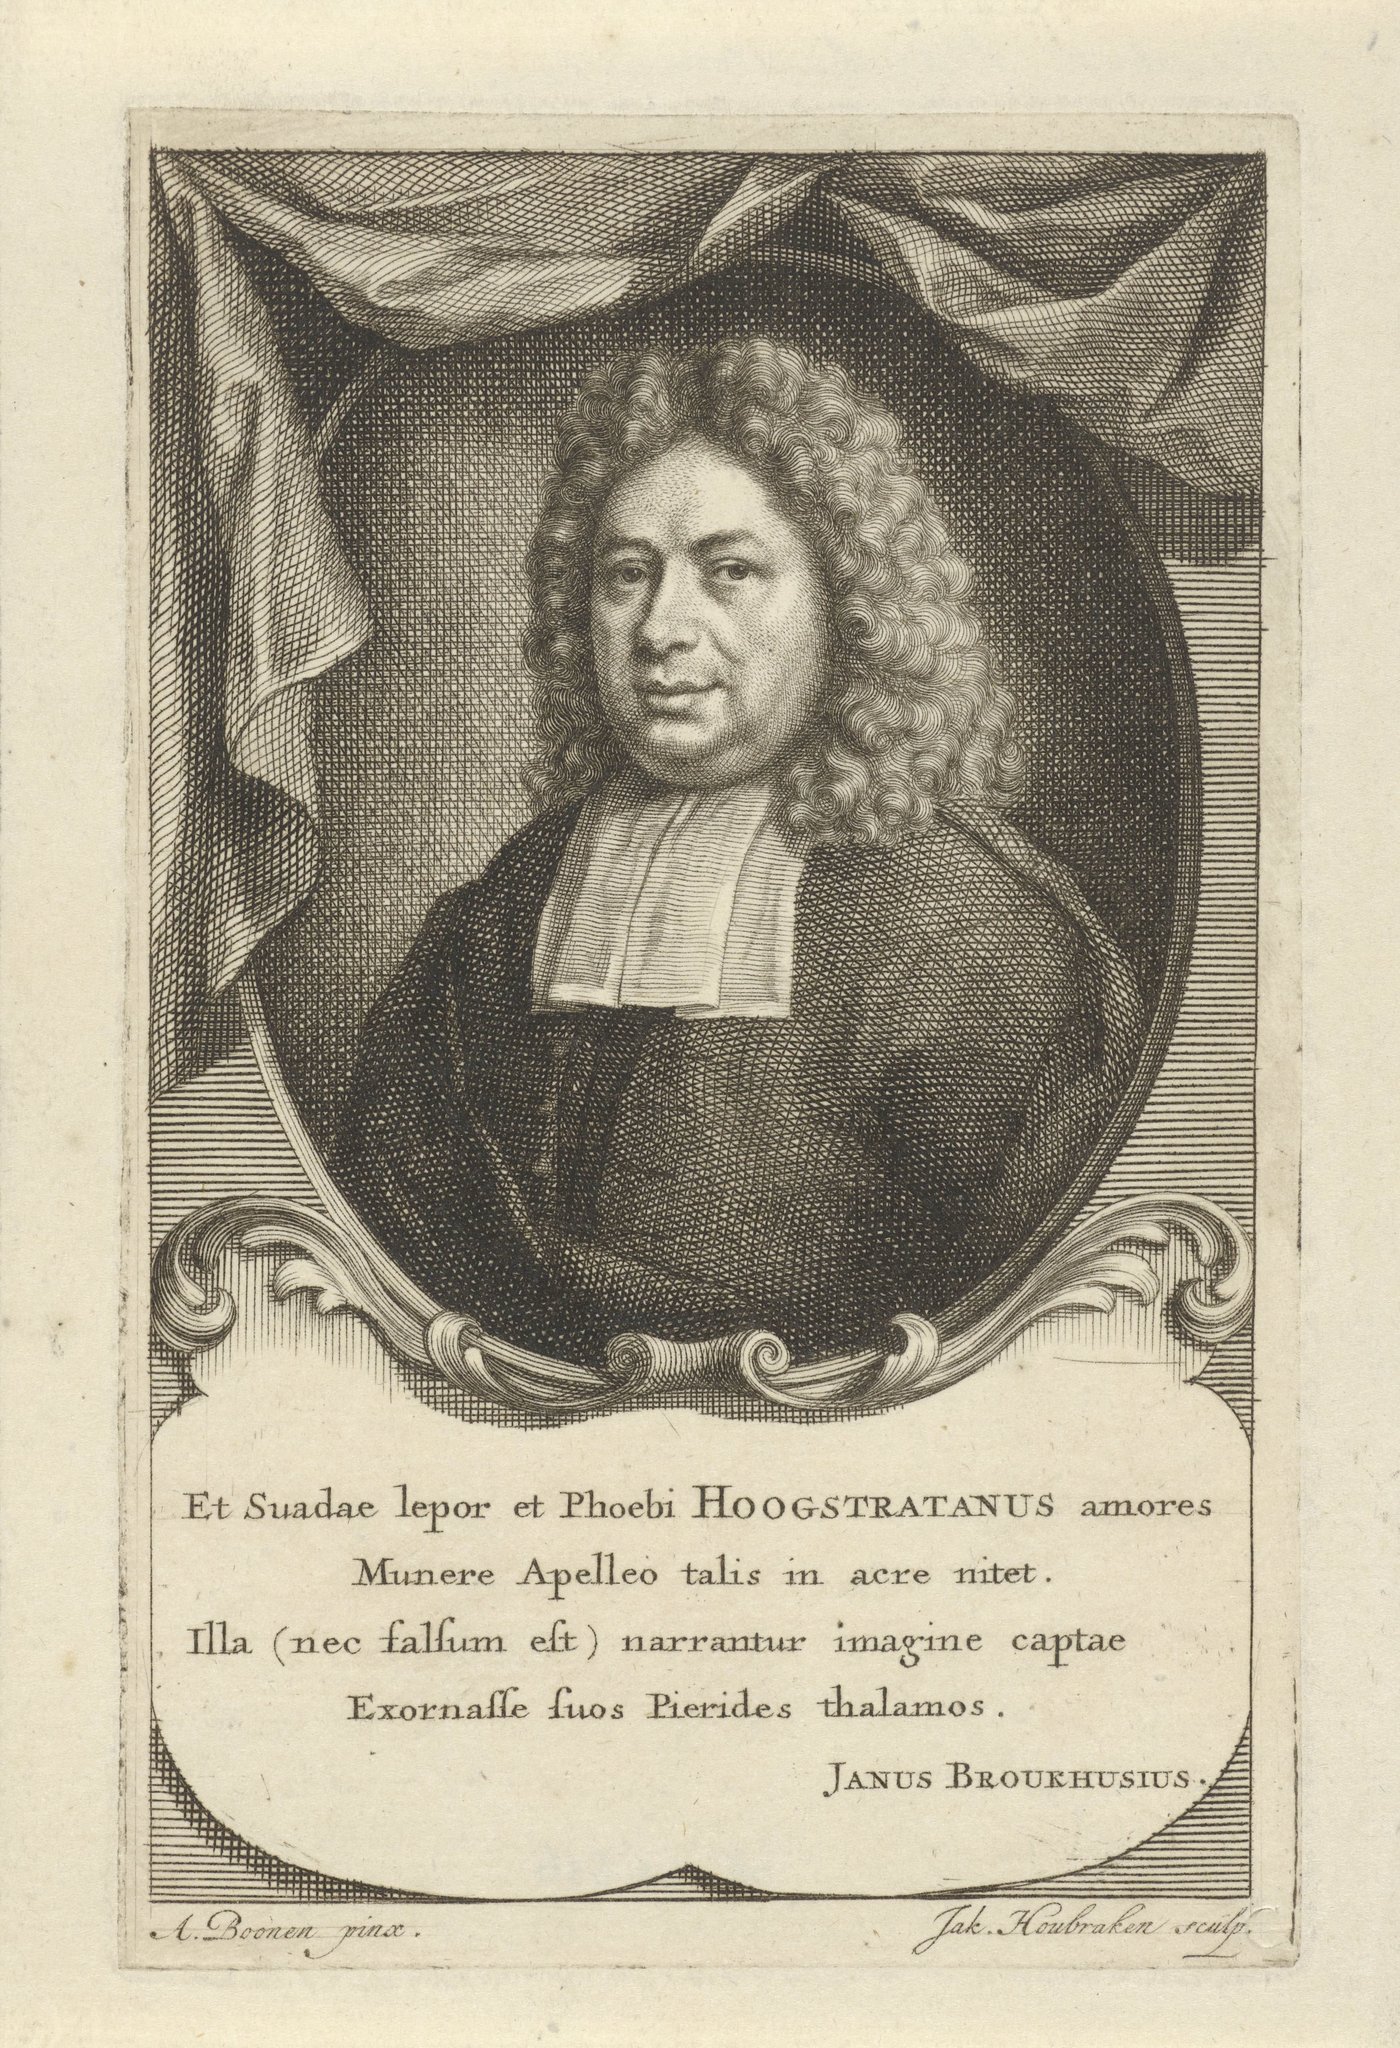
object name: print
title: Hoogstratanus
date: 1708-1780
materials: paper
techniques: engraving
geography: amsterdam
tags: rotterdam, amsterdam, david fransz. van hoogstraten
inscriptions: collector's mark: Lugt 2228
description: Portret naar links van David Fransz. van Hoogtsraten in een ovaal, waaronder een cartouche met een vierregelige tekst in het Latijn.